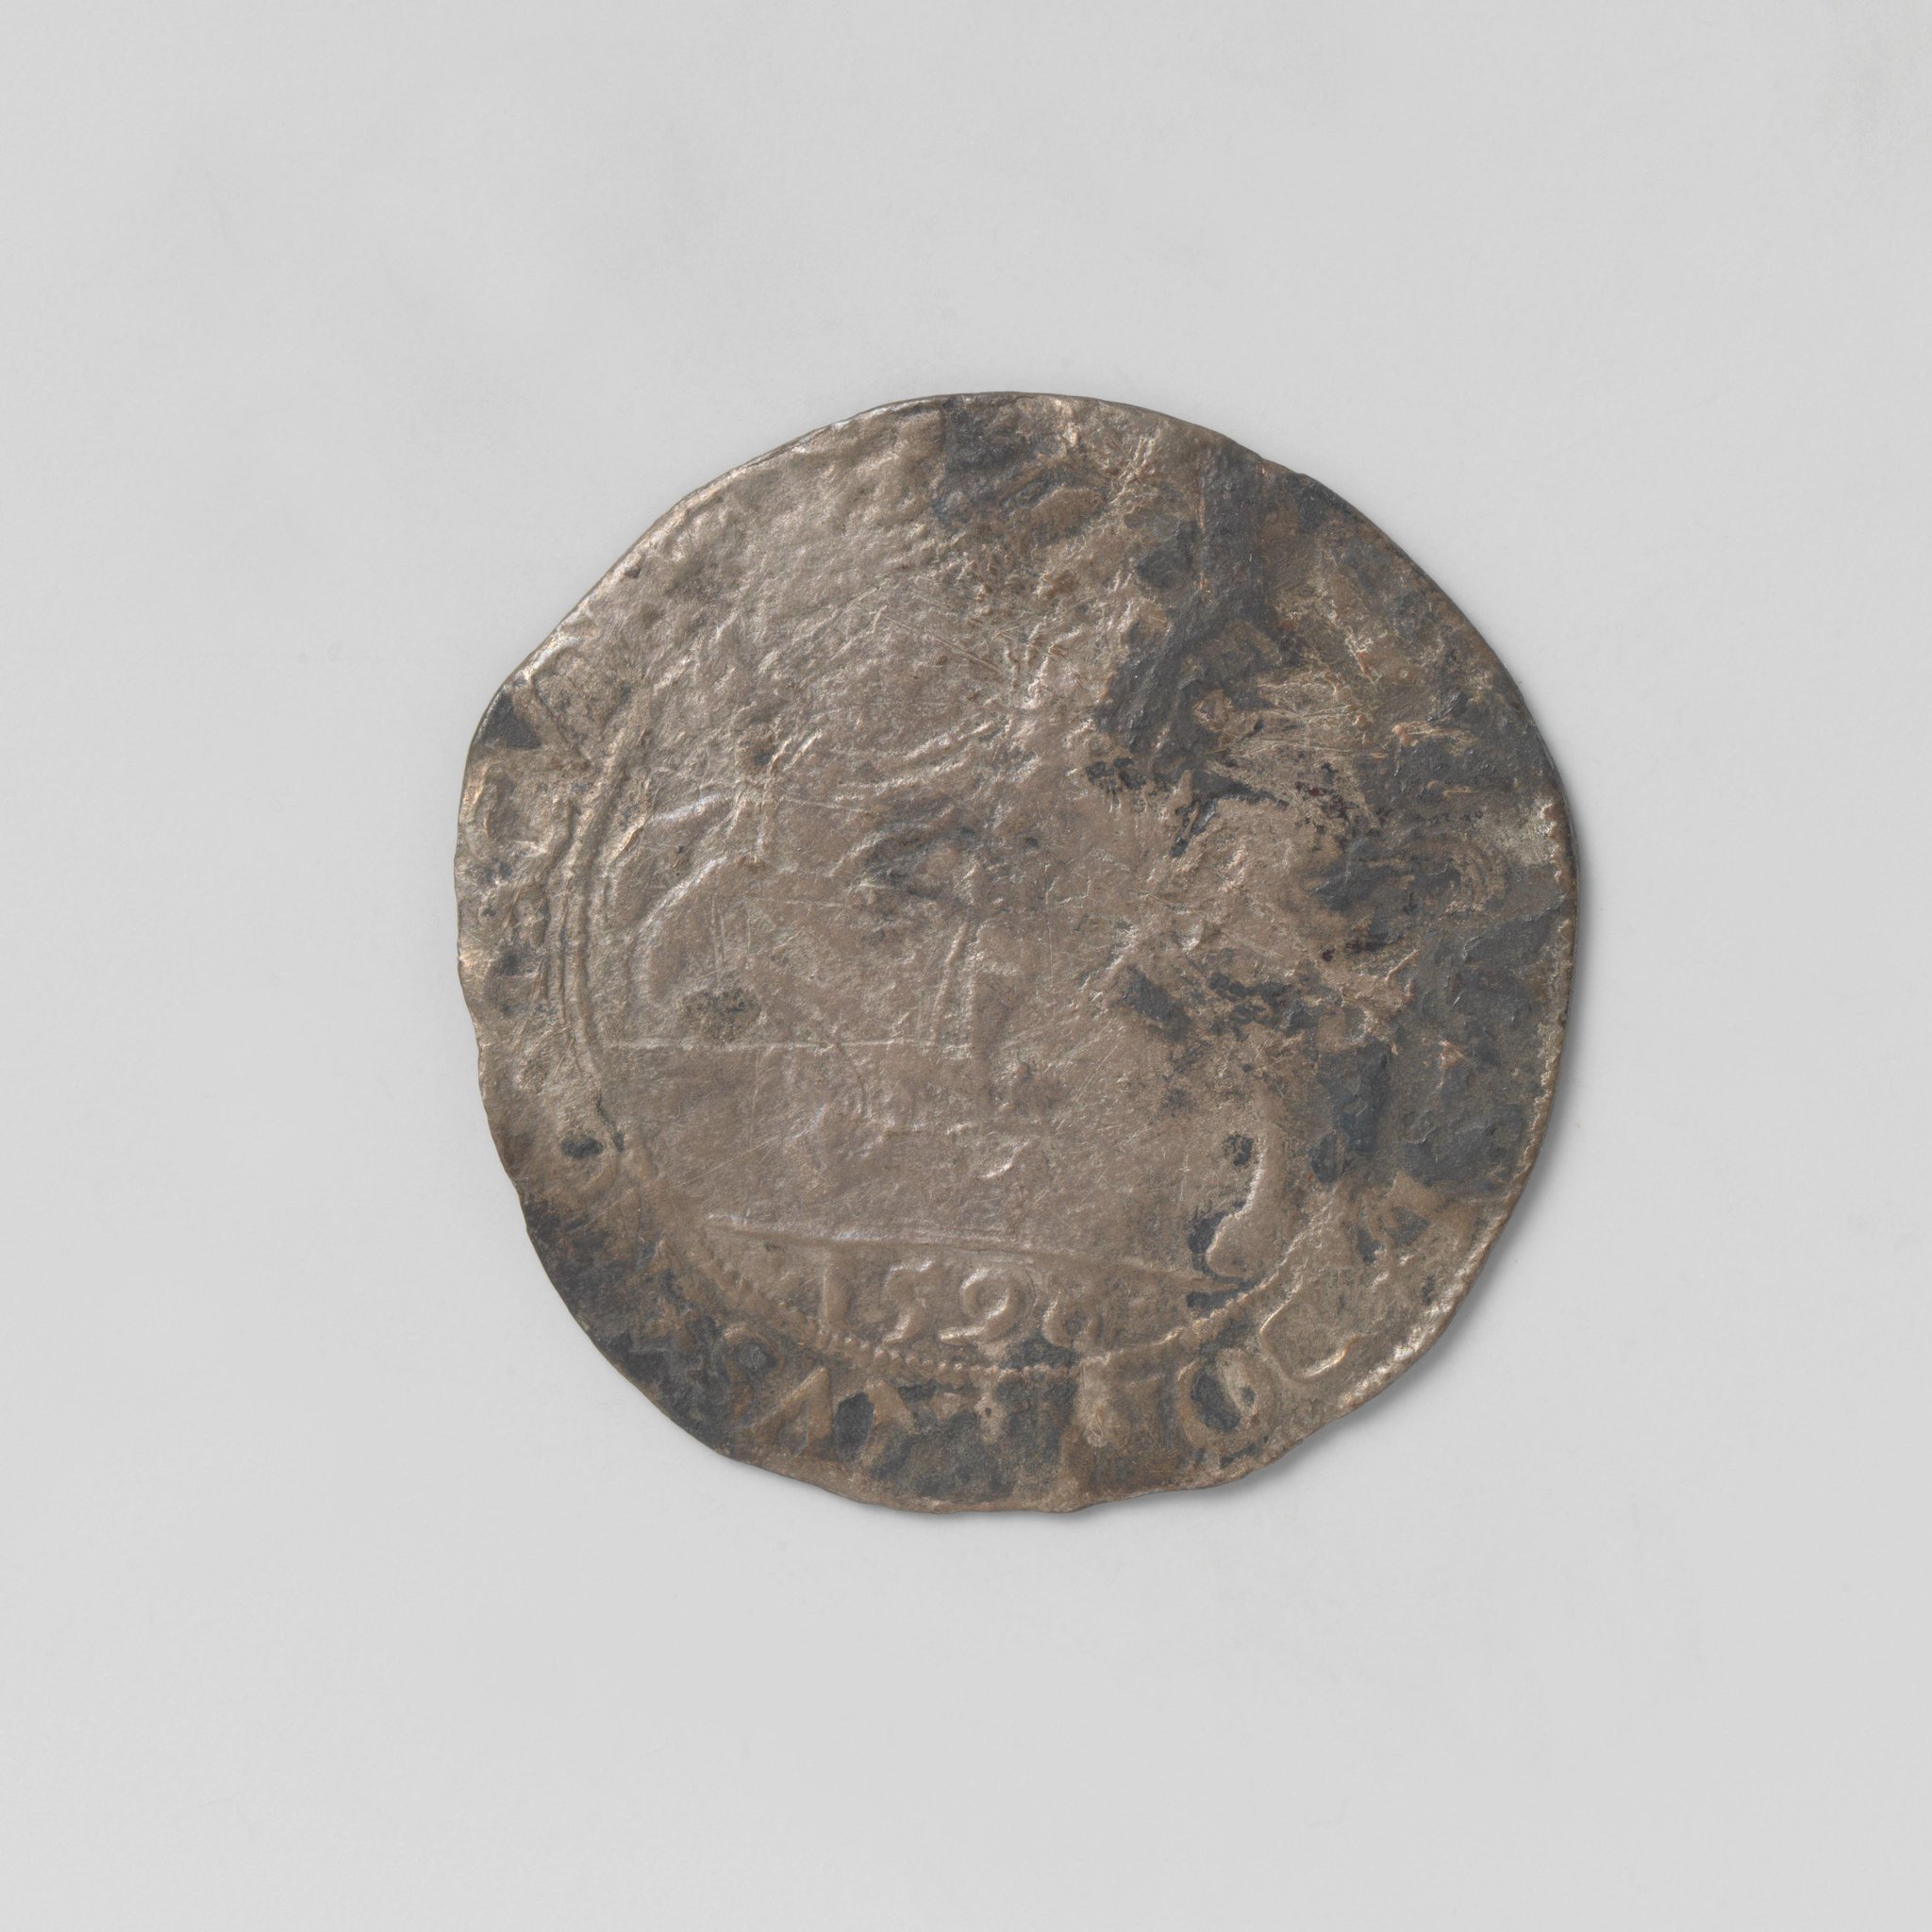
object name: coin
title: Friesland, snaphaanschelling, 1598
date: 1598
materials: silver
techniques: striking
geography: leeuwarden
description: Zilveren munt. Voorzijde: ridder te paard naar links. In rechterhand zwaard. In afsnede jaartal Keerzijde: op lang gebloemd kruis ongekroond wapenschild van Friesland.